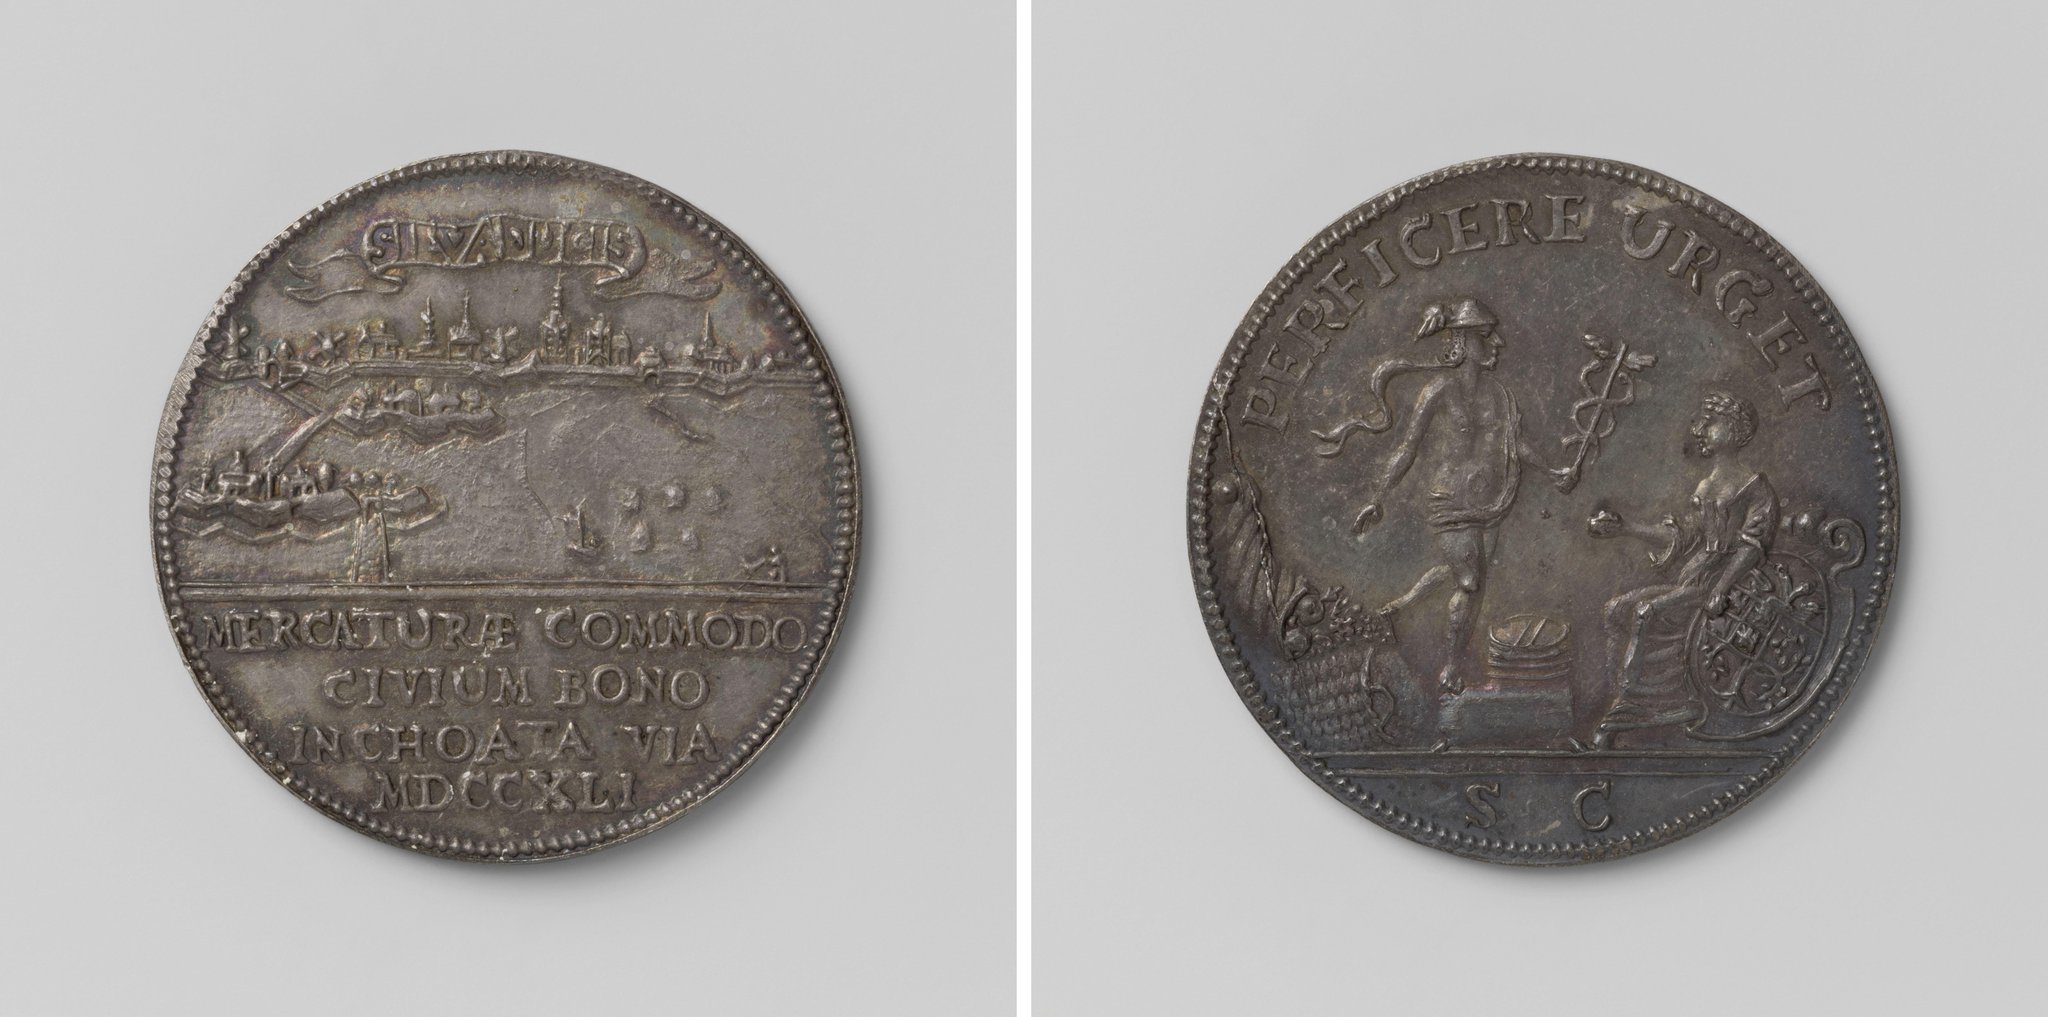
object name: council medal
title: 's-Hertogenbosch, vroedschapspenning op de aanleg van de steenweg van 's-Hertogenbosch naar Eindhoven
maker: theodorus everardus van berckel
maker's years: 1708-1770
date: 1741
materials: silver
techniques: striking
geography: den bosch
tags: den bosch